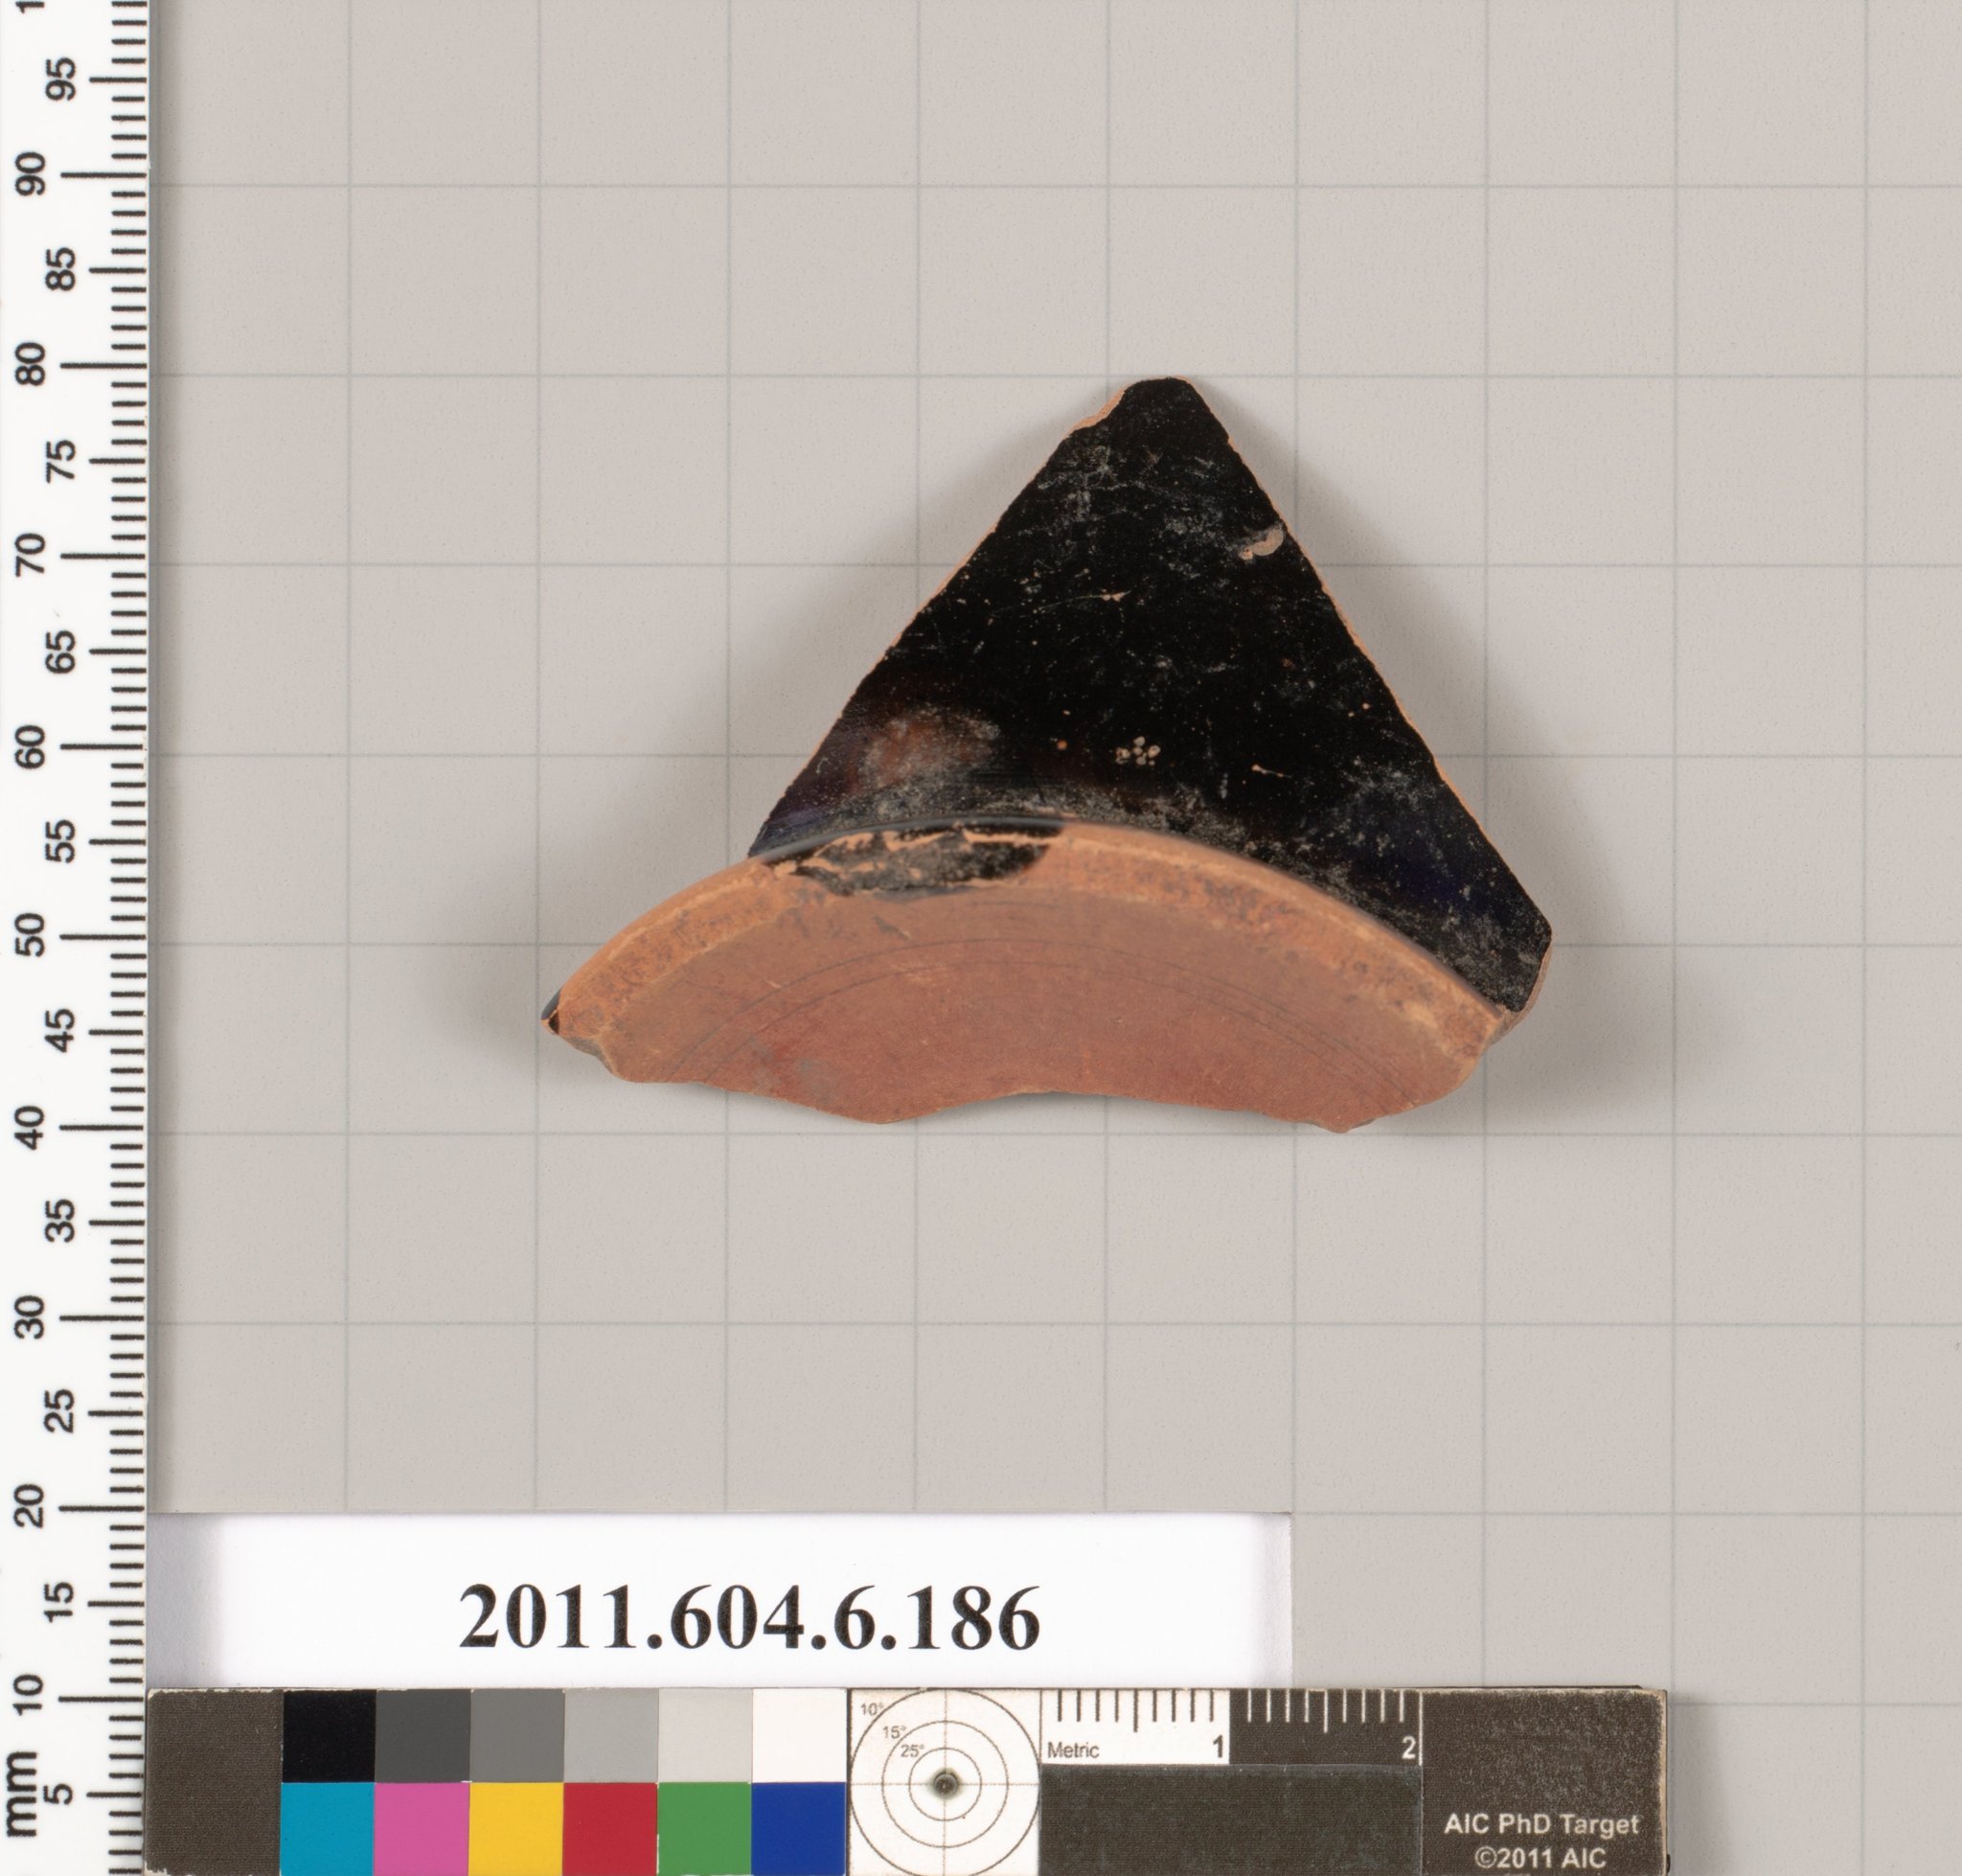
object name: squat lekythos fragment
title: Terracotta fragment of a squat lekythos (oil flask)?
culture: greek, attic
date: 500-401 BCE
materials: terracotta